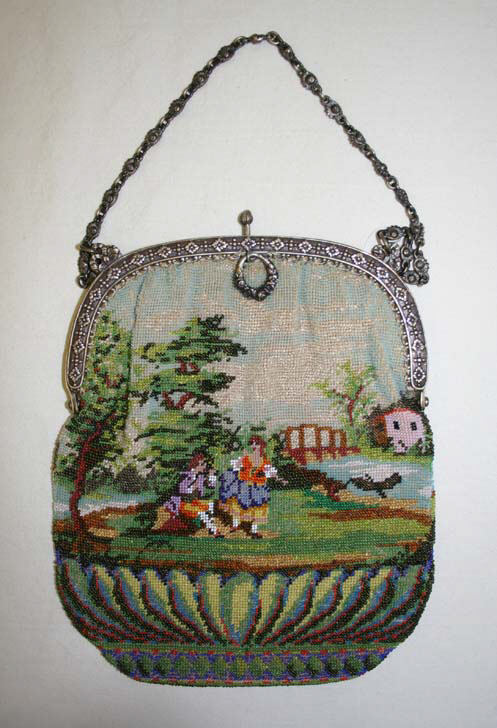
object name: bag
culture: french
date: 1834-1866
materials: silver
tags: men,women,landscapes